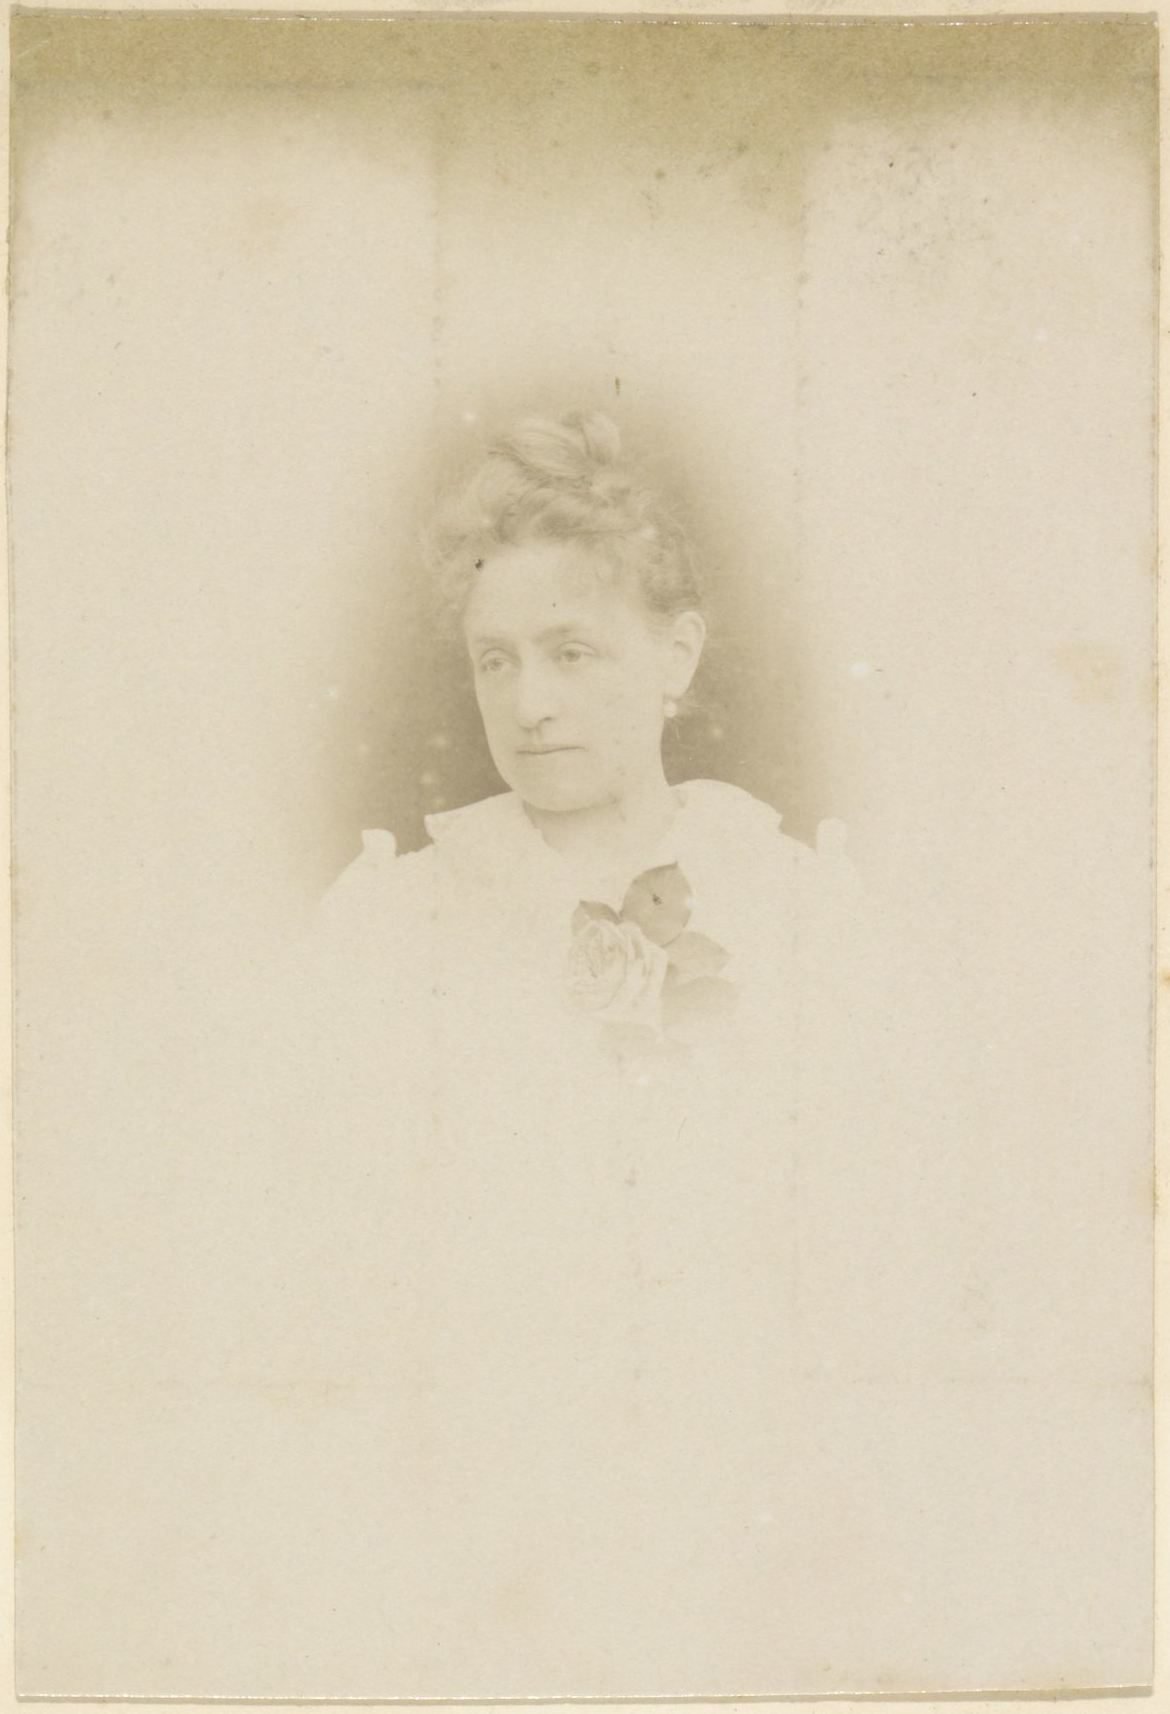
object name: photograph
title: Portret van een Franse vrouw met een roos als corsage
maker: Anonymous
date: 1900-1910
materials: paper, photographic support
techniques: albumen print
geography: france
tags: adult woman, corsage, flowers: rose, france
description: Onderdeel van Fotoalbum van een Franse amateurfotograaf met opnames van een familie, distilleerderij Delizy & Doistau Fils, het leger en bezienswaardigheden in Frankrijk.